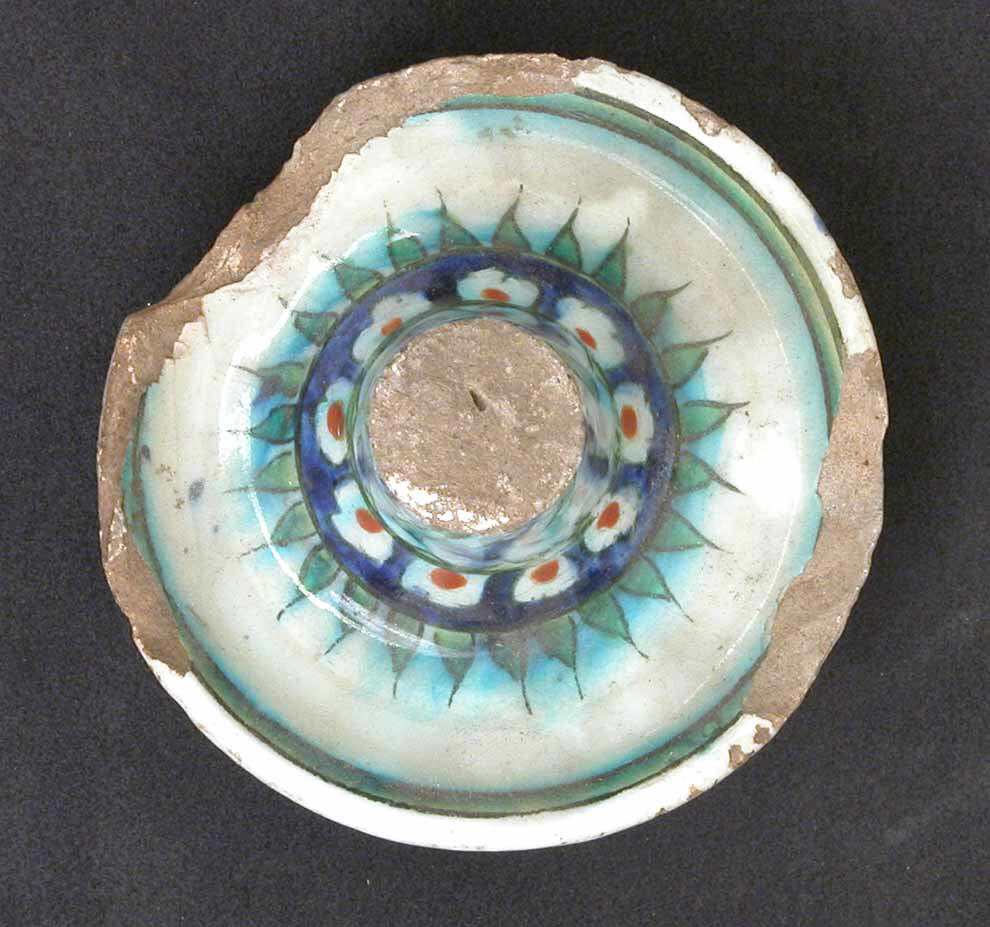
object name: fragment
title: Ceramic Fragment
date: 1501-1700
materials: glaze, stonepaste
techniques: painting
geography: turkey